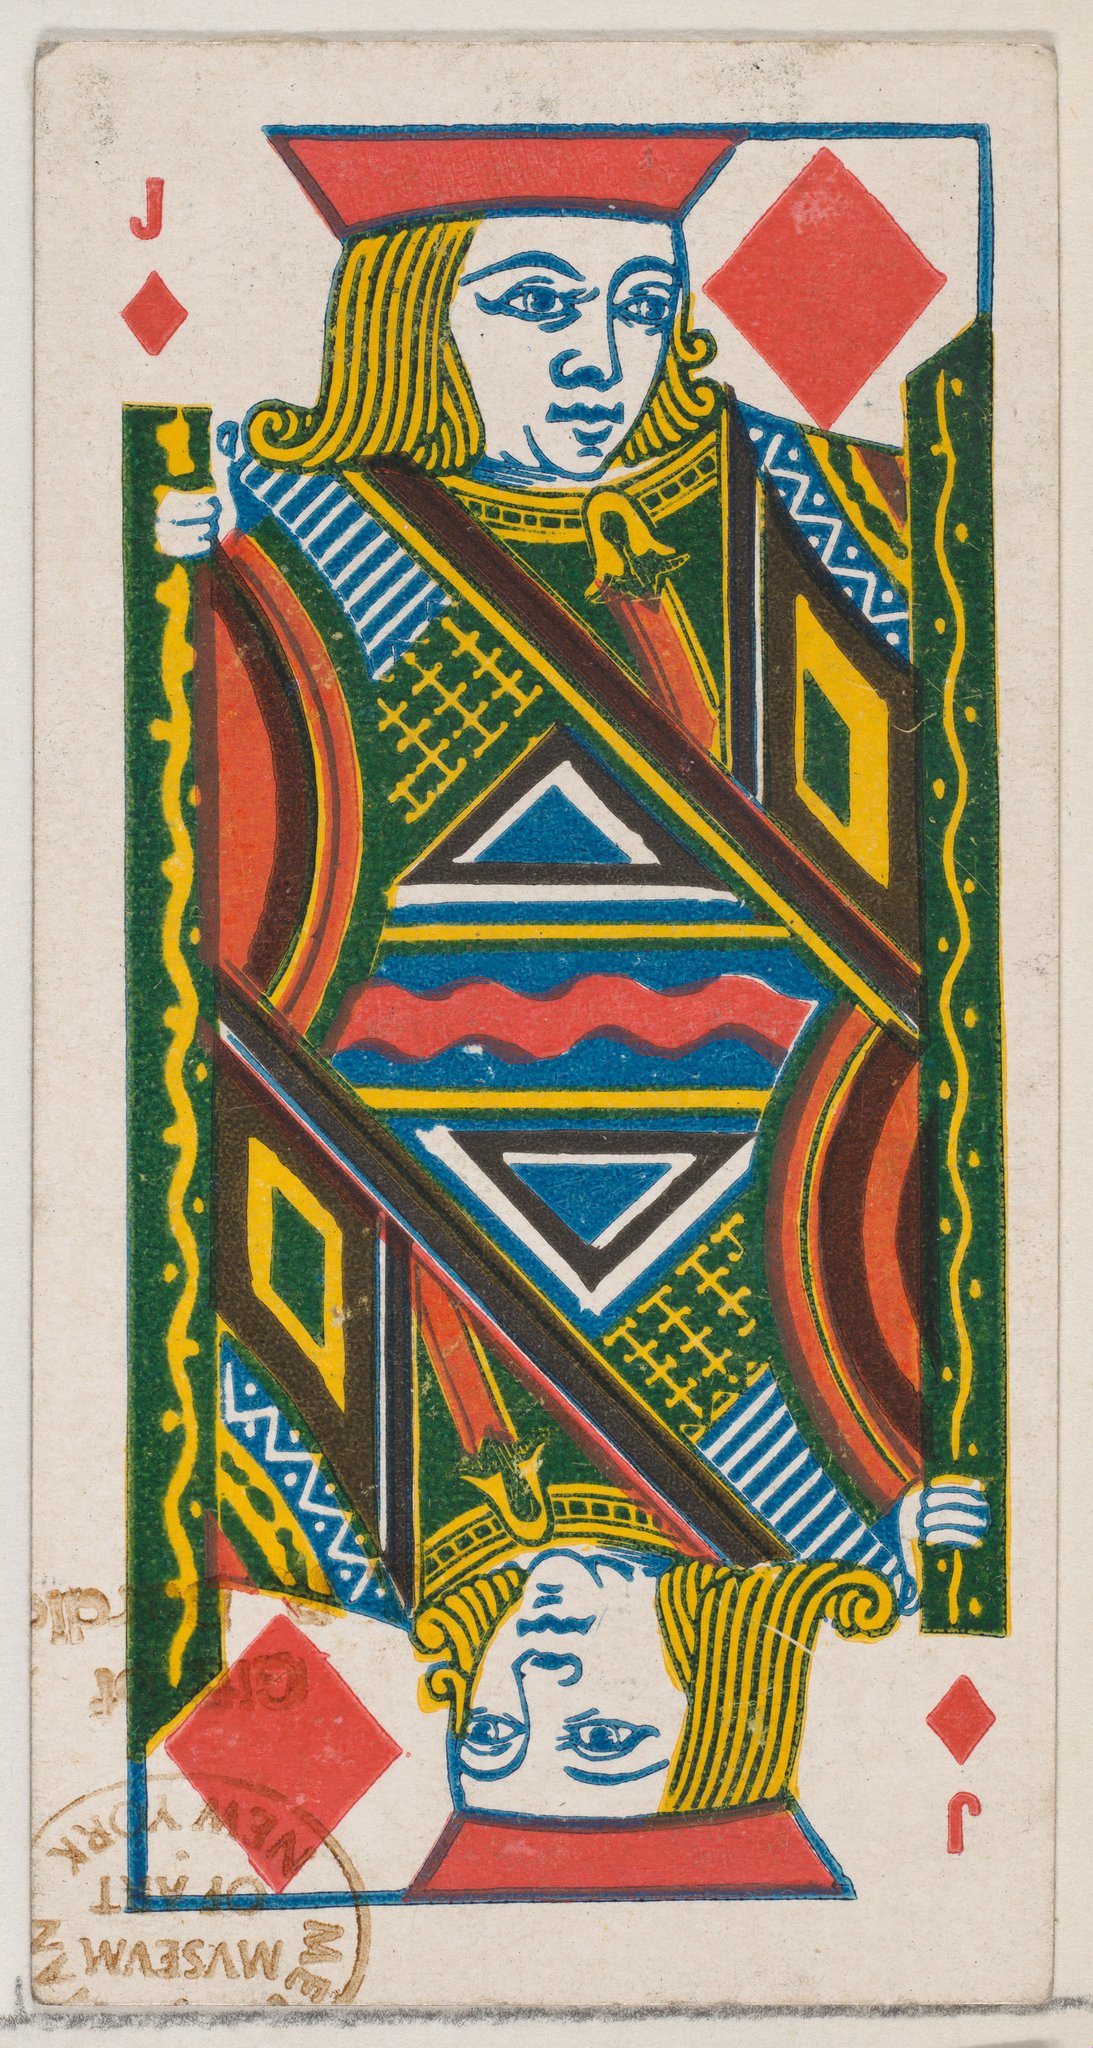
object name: print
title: Jack of Diamonds (red), from the Playing Cards series (N84) for Duke brand cigarettes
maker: w. duke, sons & co.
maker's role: publisher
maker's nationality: american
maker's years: 1870-1920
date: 1888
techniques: color lithograph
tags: playing cards